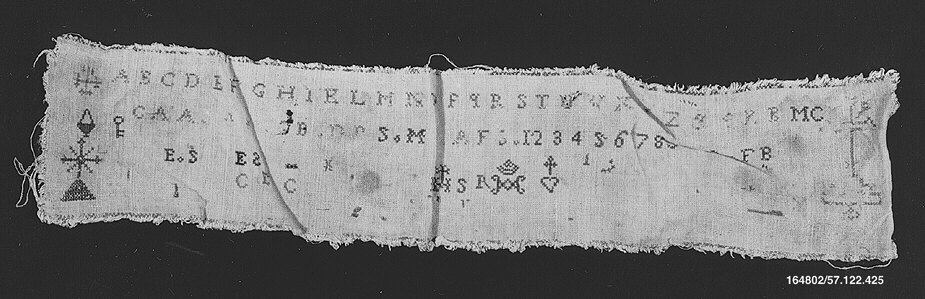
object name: sampler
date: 1801-1900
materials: cotton, linen